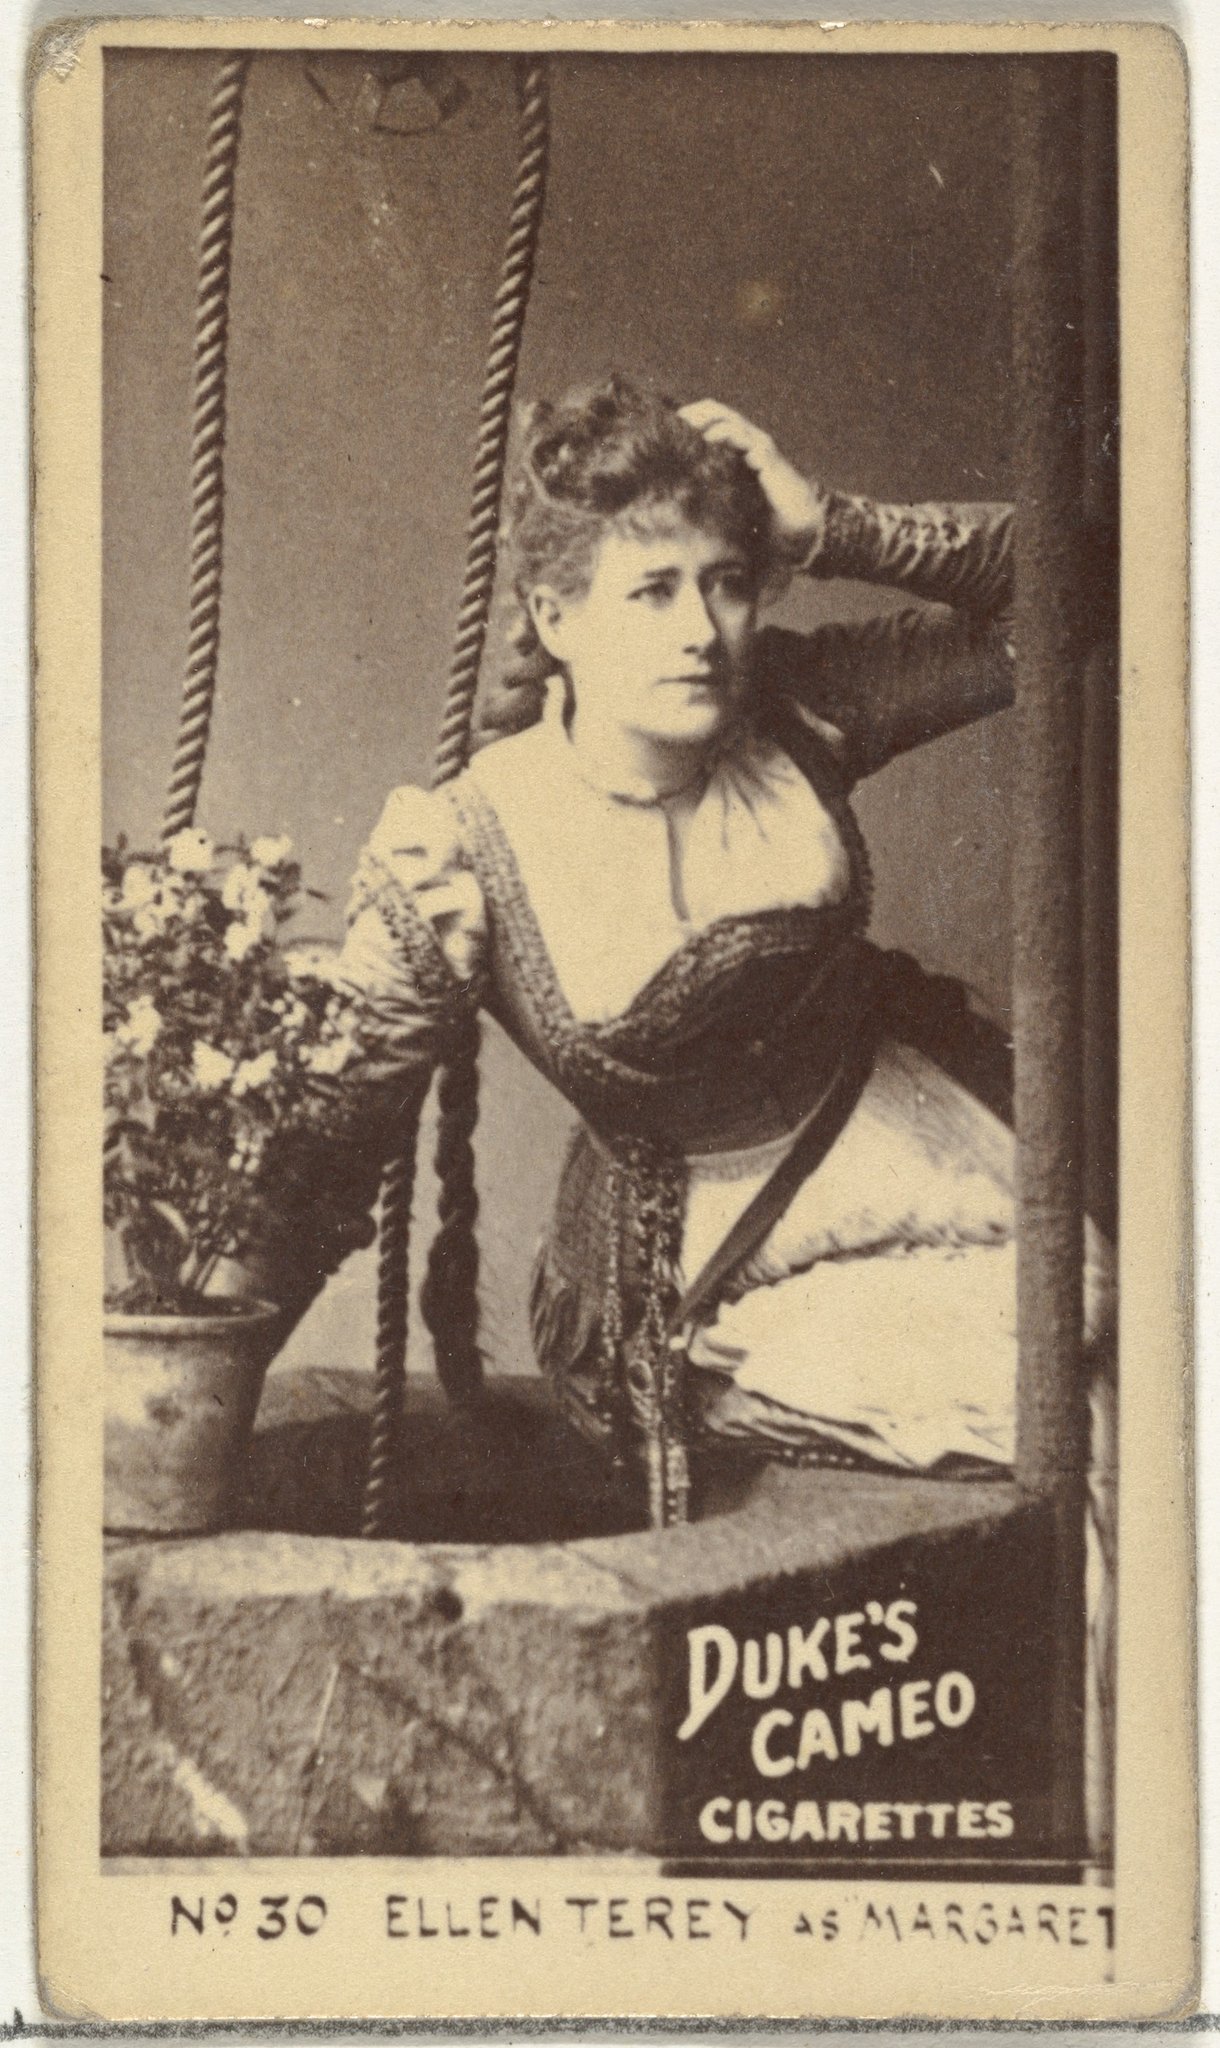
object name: photograph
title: Card Number 30, Ellen Terey as Margaret, from the Actors and Actresses series (N145-4) issued by Duke Sons & Co. to promote Cameo Cigarettes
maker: w. duke, sons & co.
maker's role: publisher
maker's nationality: american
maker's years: 1870-1920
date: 1880-1889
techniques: albumen silver print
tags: portraits,women,actresses